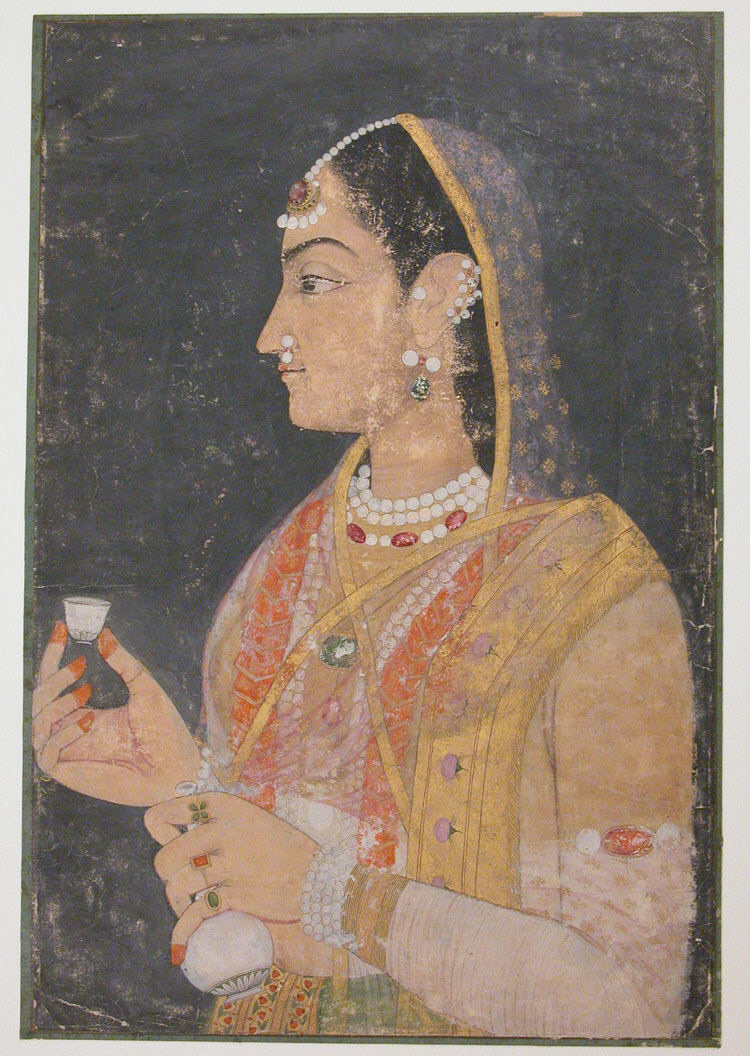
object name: illustrated album leaf or single work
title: Portrait of a Woman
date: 1701-1800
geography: india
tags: profiles,women